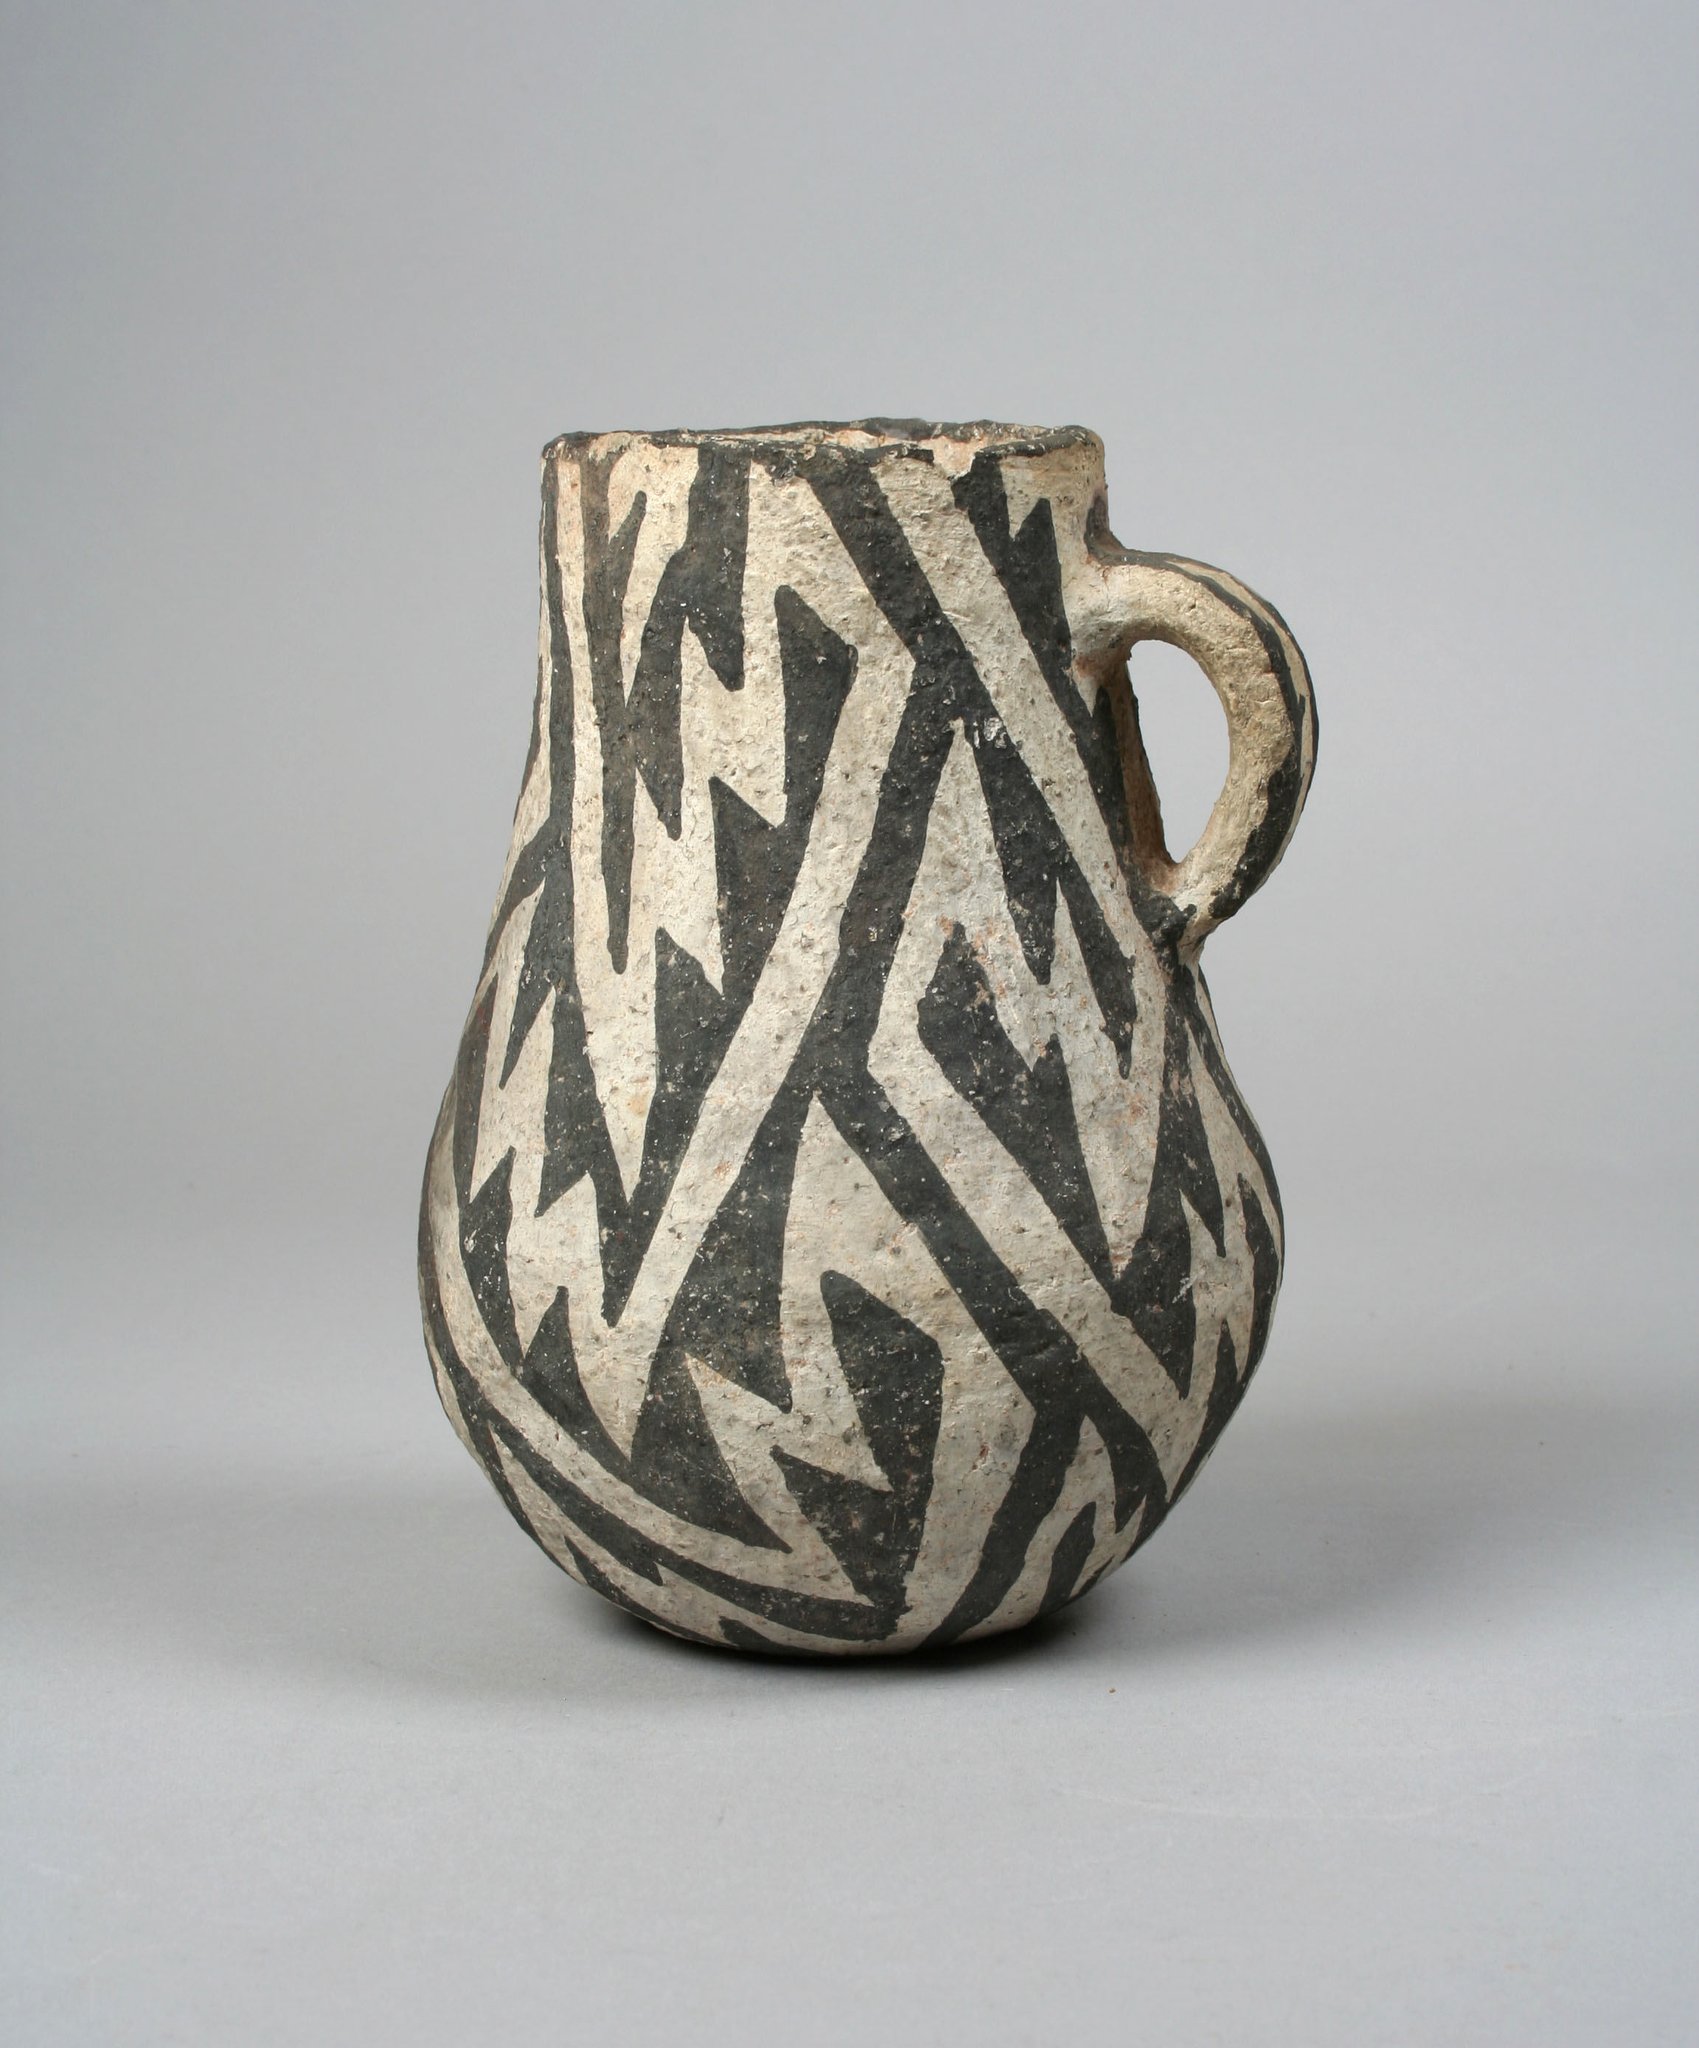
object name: jug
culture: ancestral pueblo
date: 1101-1800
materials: ceramic, pigment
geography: united states